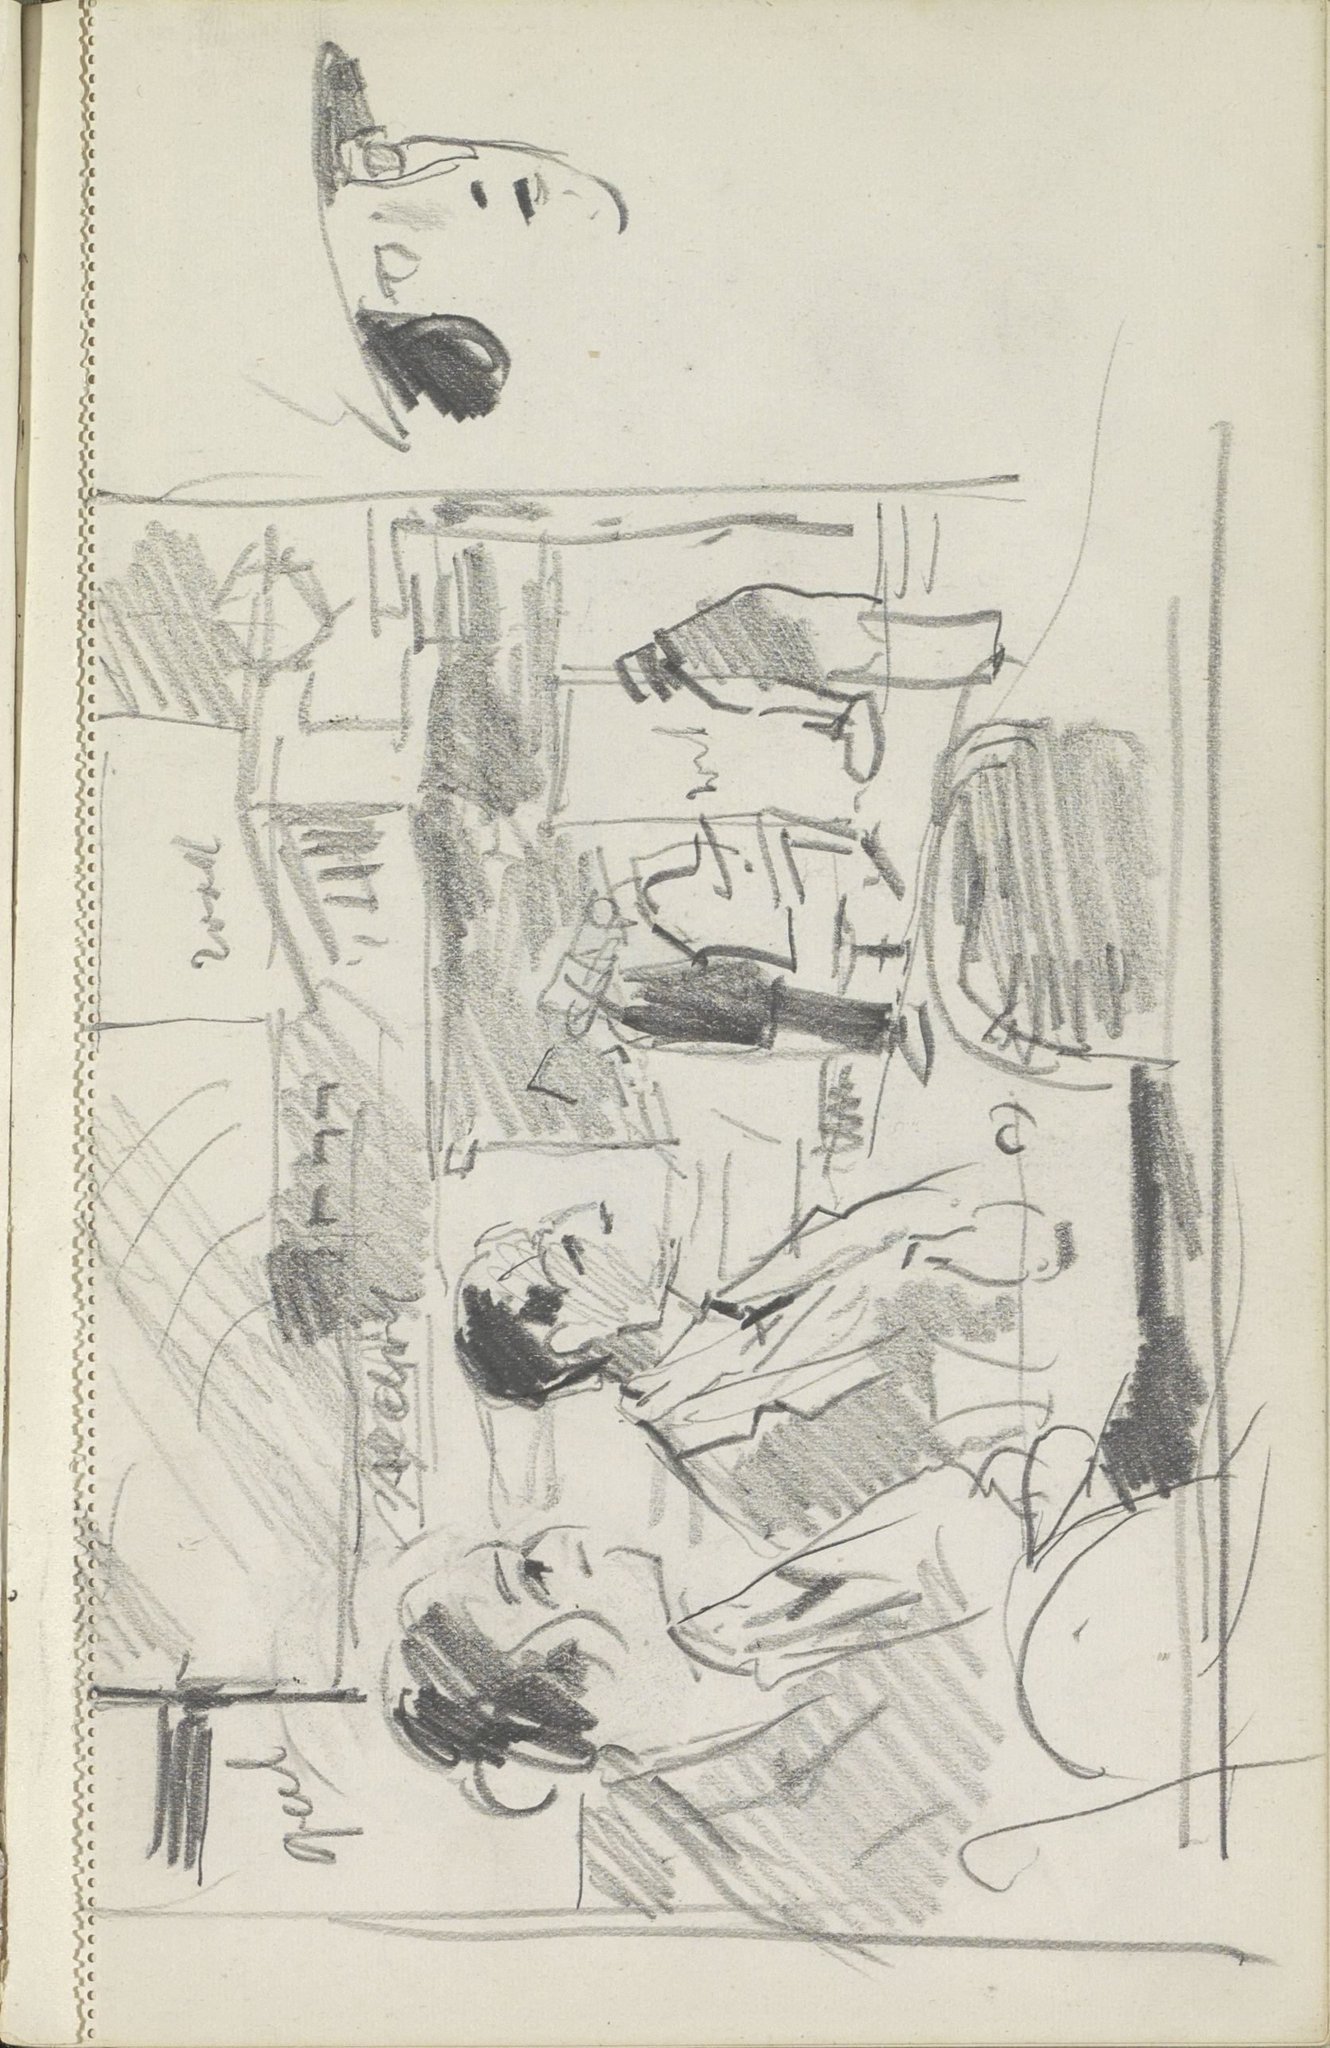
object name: sketchbook leaf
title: Man en vrouw in een café uitkijken over een straat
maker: cornelis vreedenburgh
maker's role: draughtsman, print maker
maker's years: 1880-1946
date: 1890-1946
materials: paper, pencil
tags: sitting figure, inn, coffee-house, public house, etc., street (+ city(-scape) with figures, staffage)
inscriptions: kleurnotitie, handgeschreven in potlood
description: Mogelijk zitten de figuren buiten op een terras. Tevens een studie van een vrouw met een hoed. Blad 19 recto uit een schetsboek met 50 bladen.